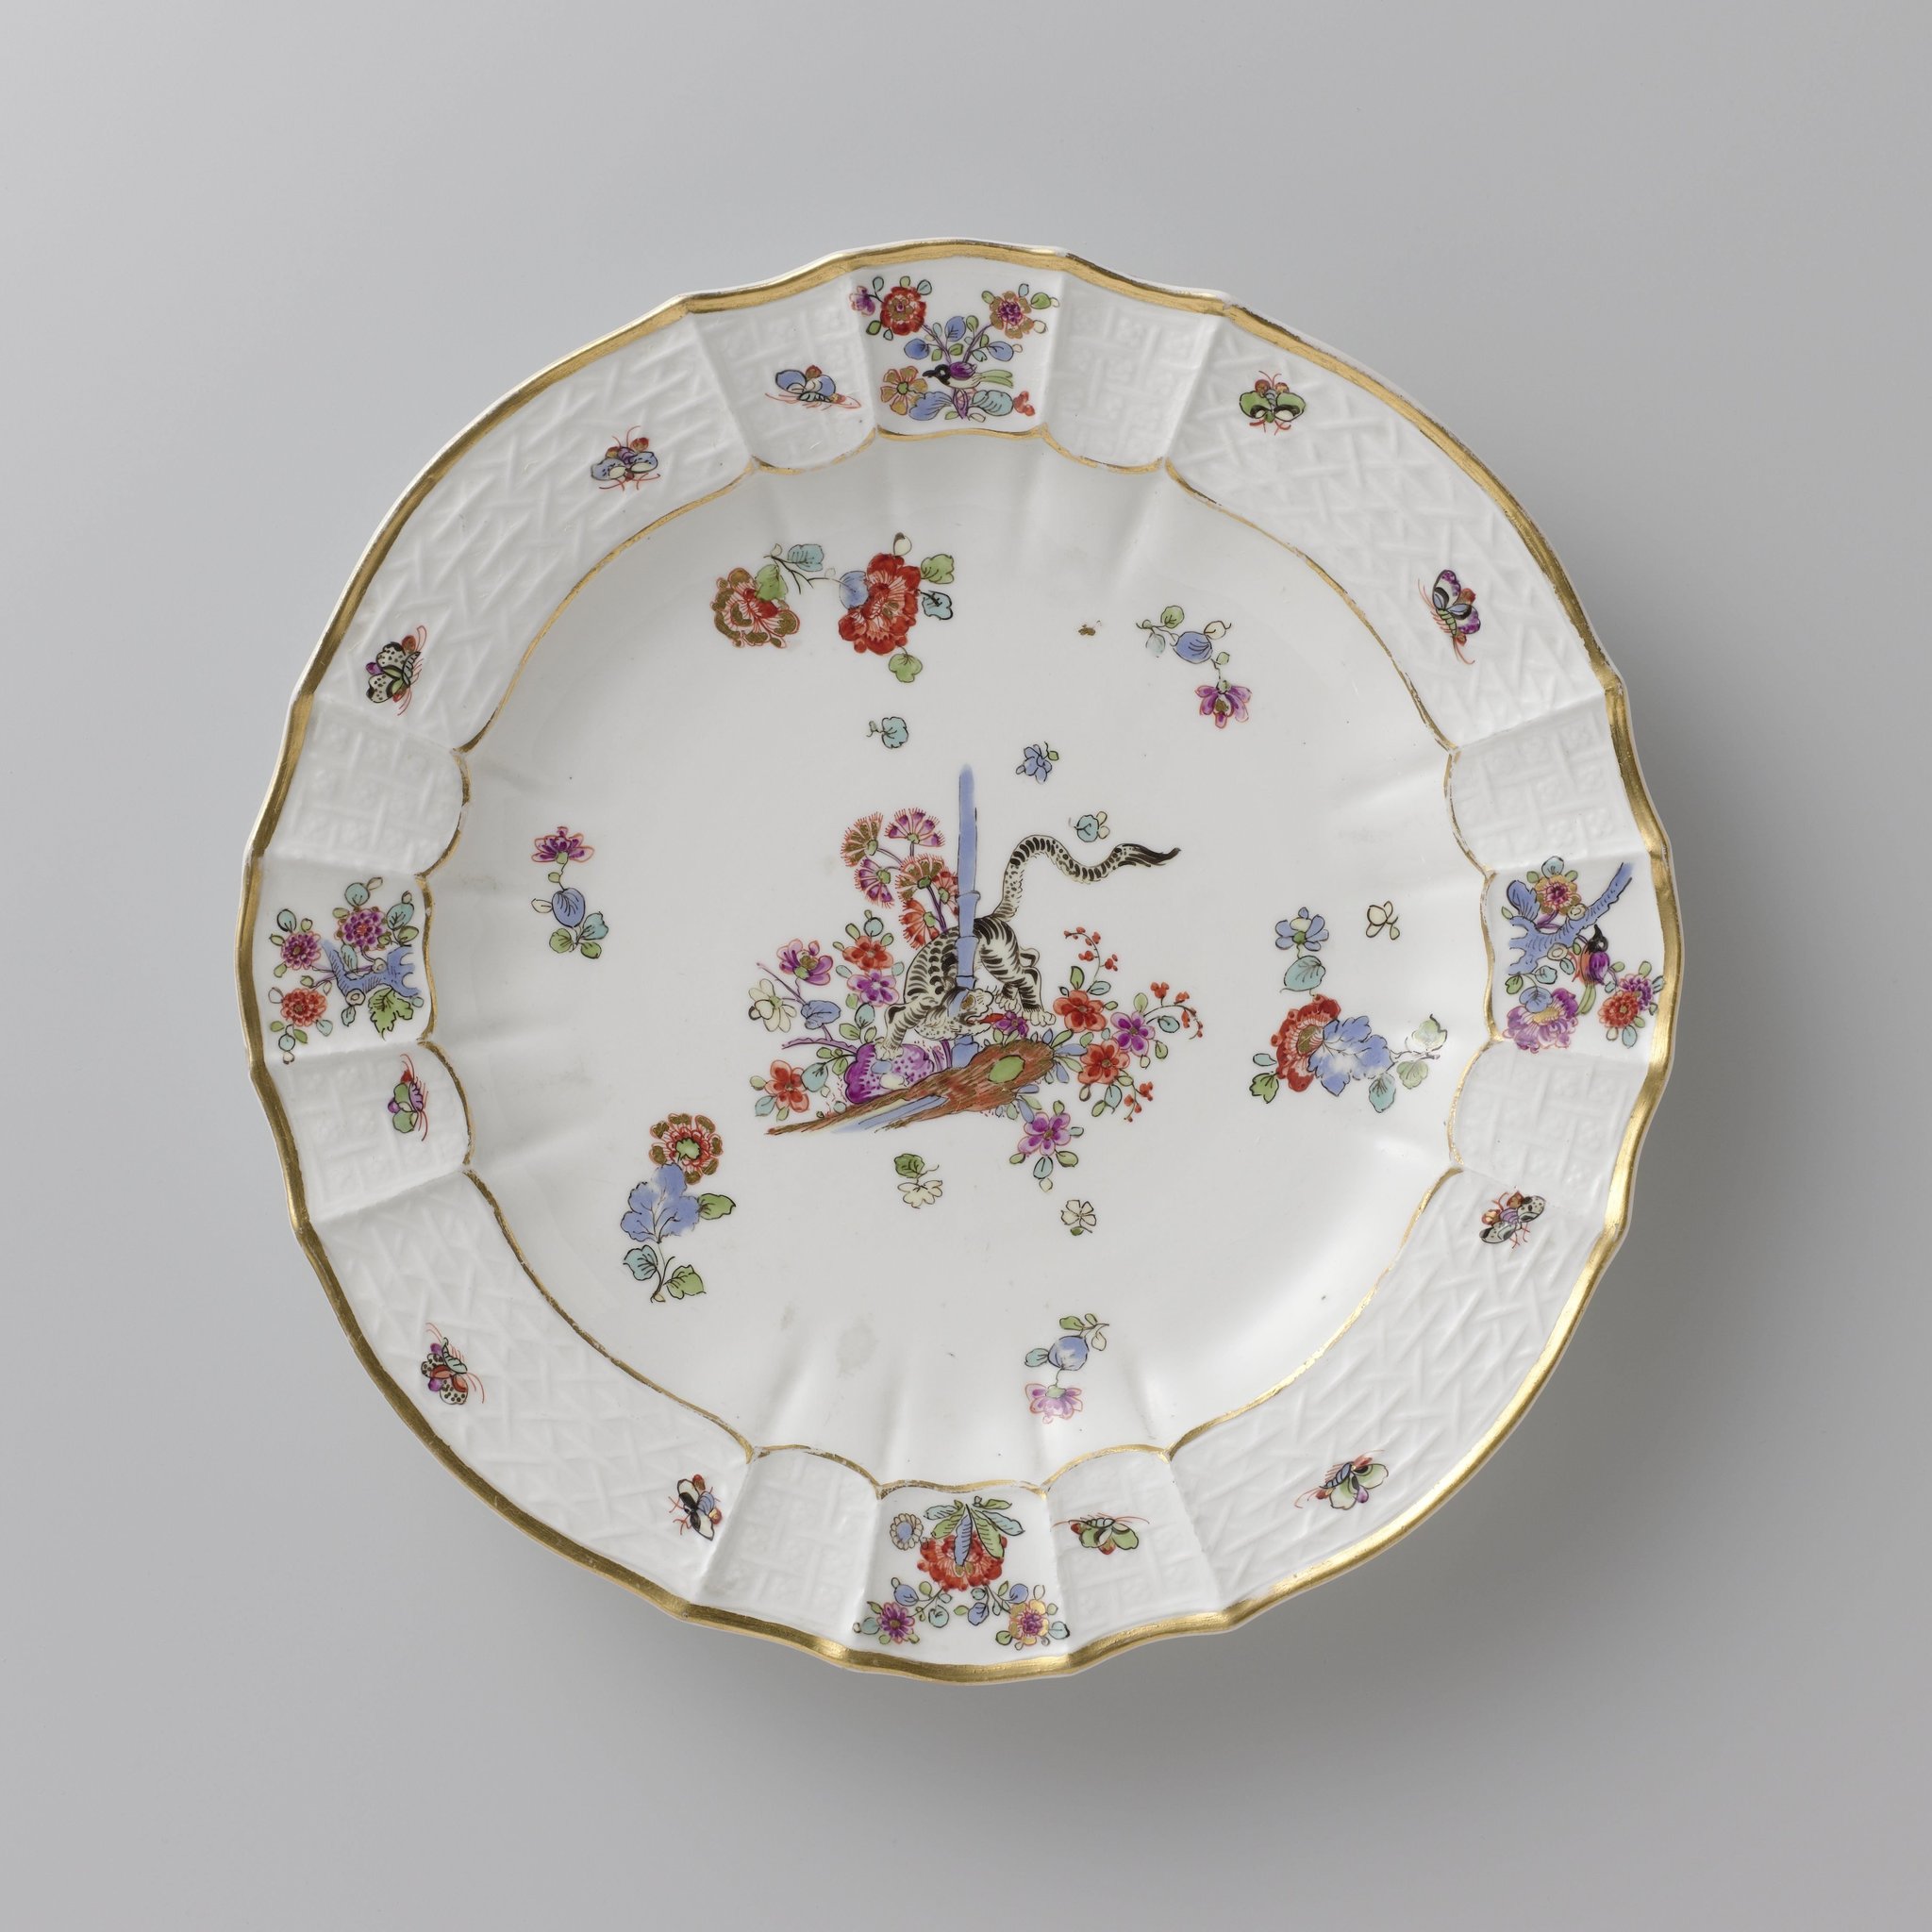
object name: plate dish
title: Rond bord, veelkleurig beschilderd met een Kakiemon-decor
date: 1740-1745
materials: porcelain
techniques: painted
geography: meissen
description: Rond bord van beschilderd porselein. Het bord is geribd en heeft een geschulpte rand. Het bord is beschilderd met een tijger die om een blauwe bamboestengel tussen bloemen is gedraaid, gestrooide Indianische Blumen, vlinders en takken waarop vogels. De rand is versierd met het 'Altbrandenstein'-patroon. Het bord is gemerkt.